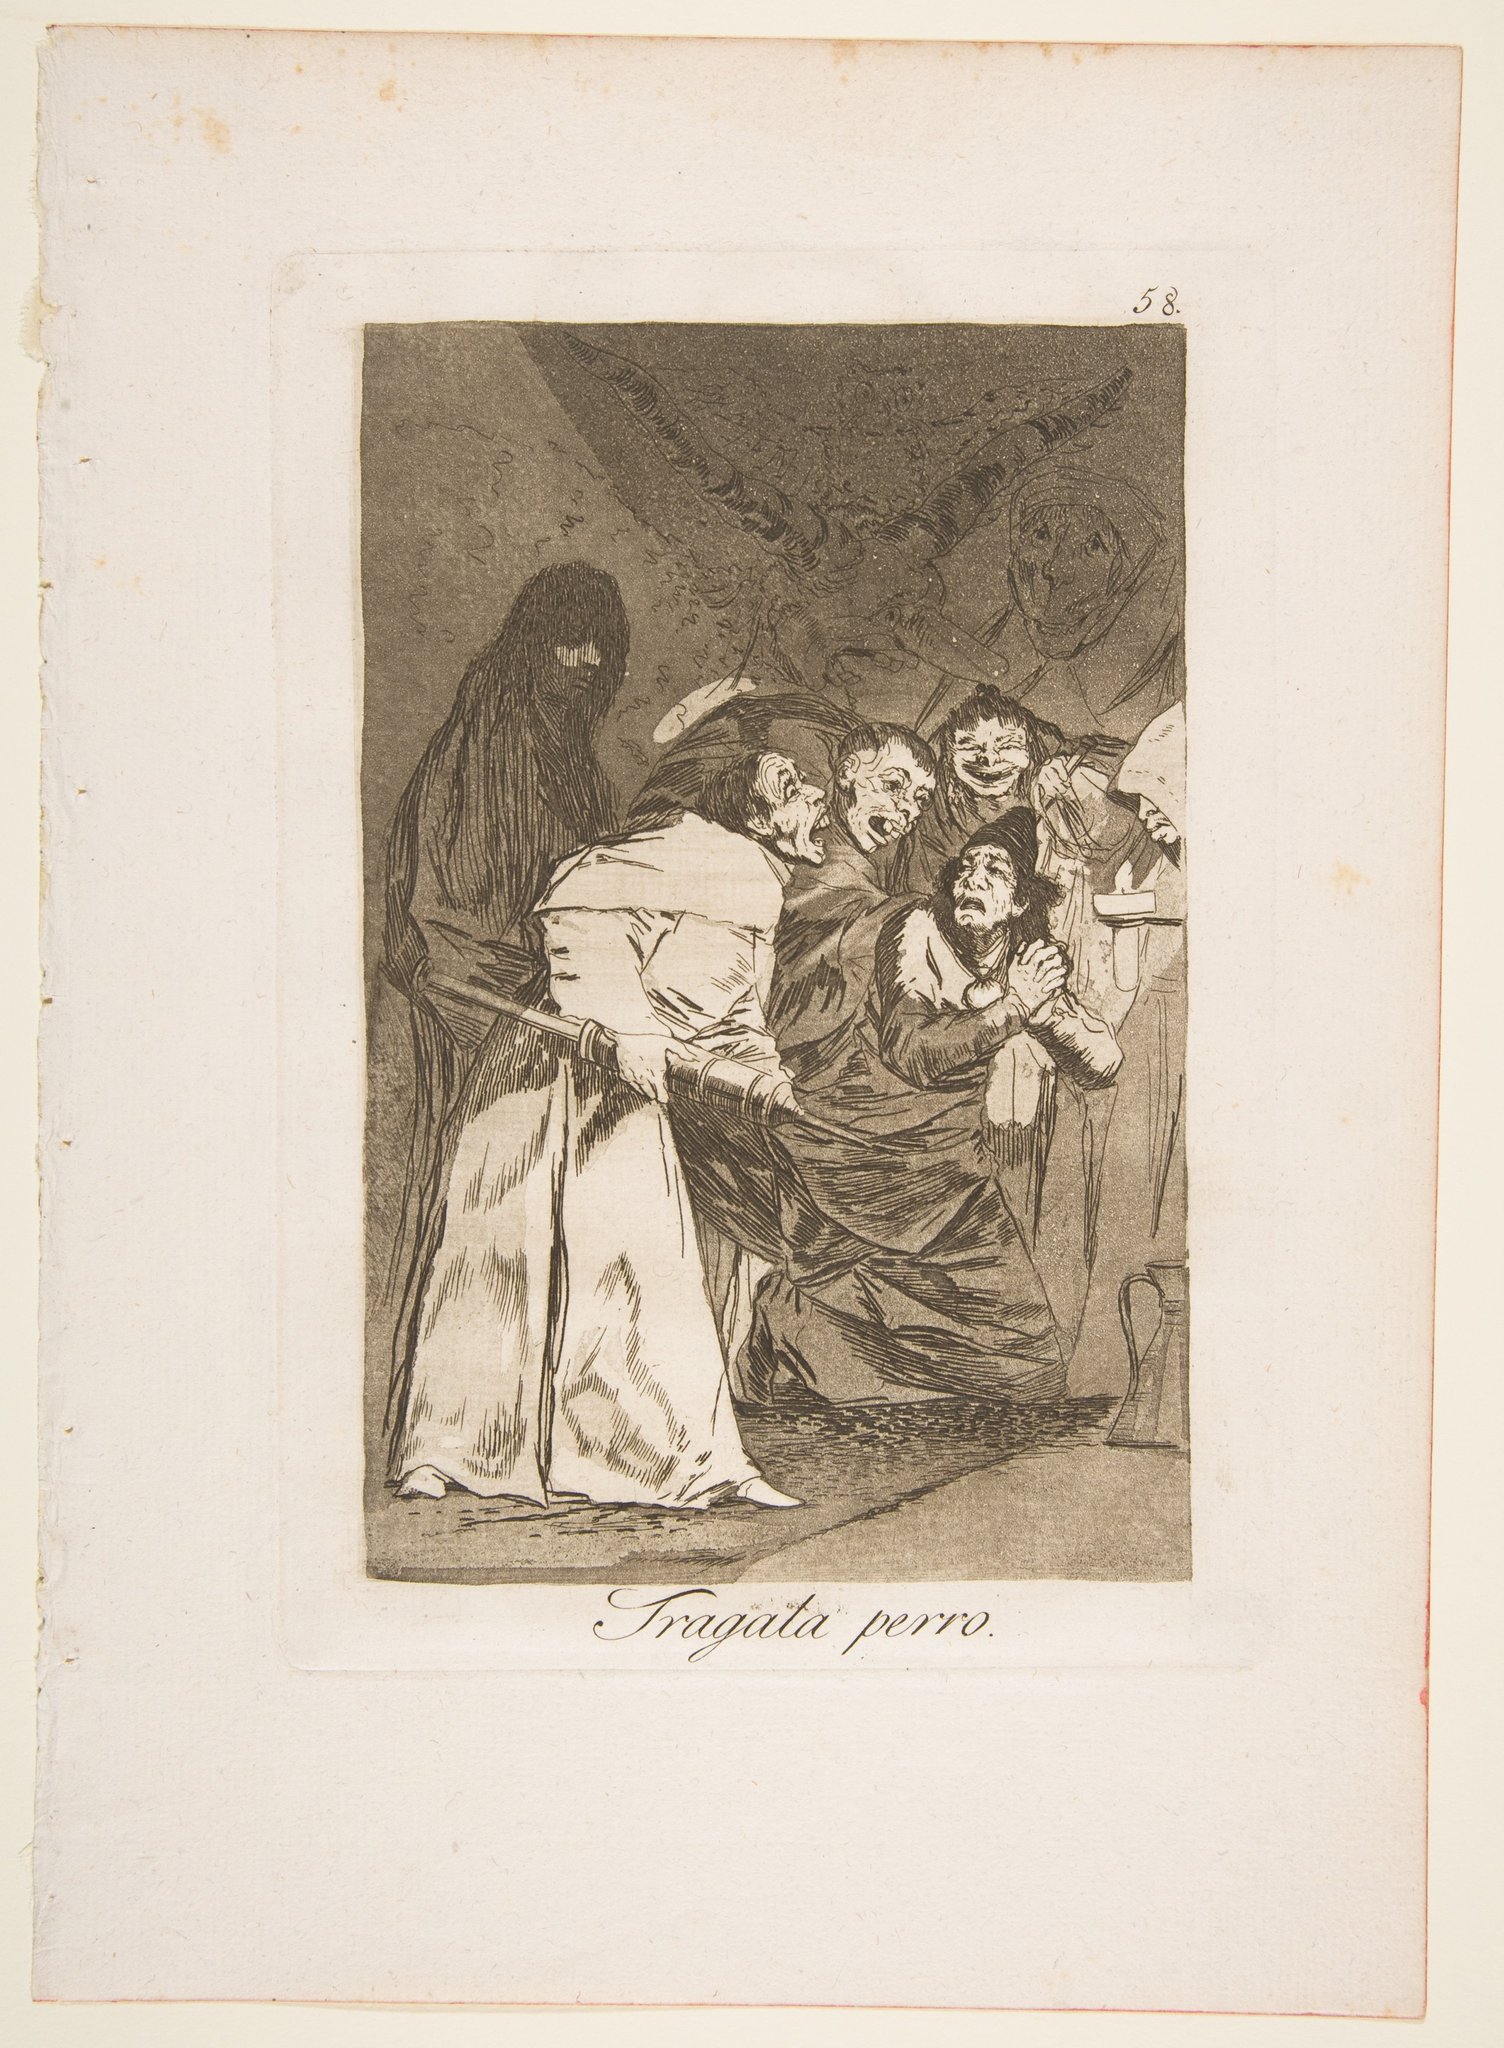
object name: print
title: Plate 58 from "Los Caprichos": Swallow it, dog (Tragala perro)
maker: goya (francisco de goya y lucientes)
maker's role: artist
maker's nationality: spanish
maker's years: 1746-1828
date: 1799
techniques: aquatint, burnishing, drypoint, etching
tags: fear,men